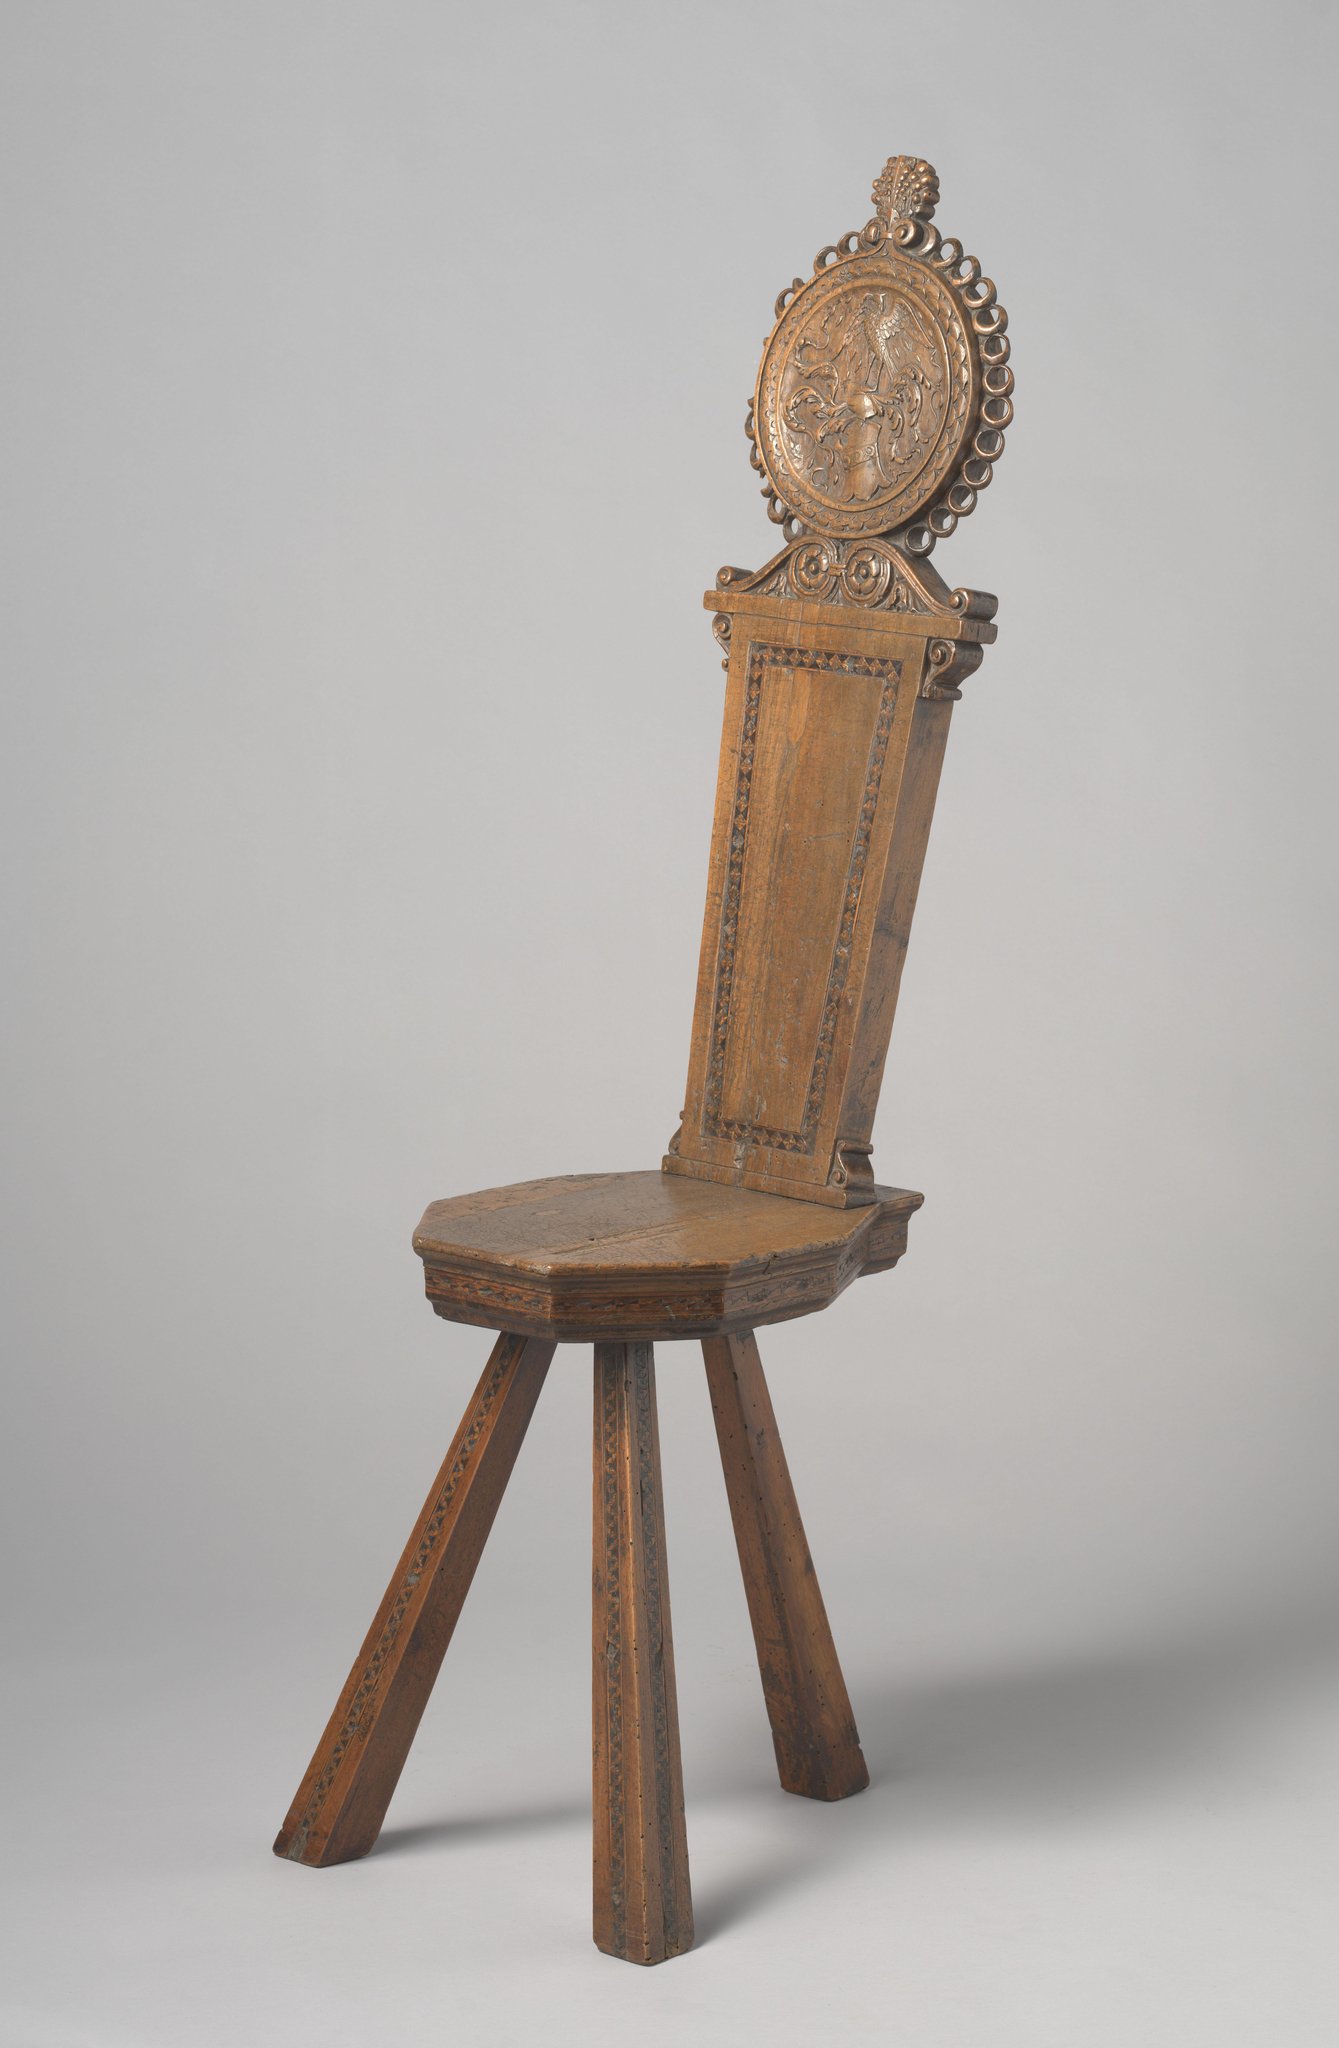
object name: seating furniture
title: Sgabello van notenhout versierd met intarsia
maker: Anonymous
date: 1490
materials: wood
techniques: intarsia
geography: florence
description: Notenhouten sgabello versierd met intarsia, rustend op drie in gespreide stand geplaatste, in doorsnede vierkante naar onder zich verbredende poten. De poten, de achthoekige zitting en het gestrekt trapeziumvormige rugraam dragen randen met intarsia. De onder- en bovenkant van de rugstijlen tonen een voluut; op de bovendorpel liggen twee acanthusvoluten die een medaillon dragen, omgeven door een rand van halve manen en bekroond met een palmet, dat aan twee kanten het wapen der Strozzi toont. Zie: BK-16878-a.